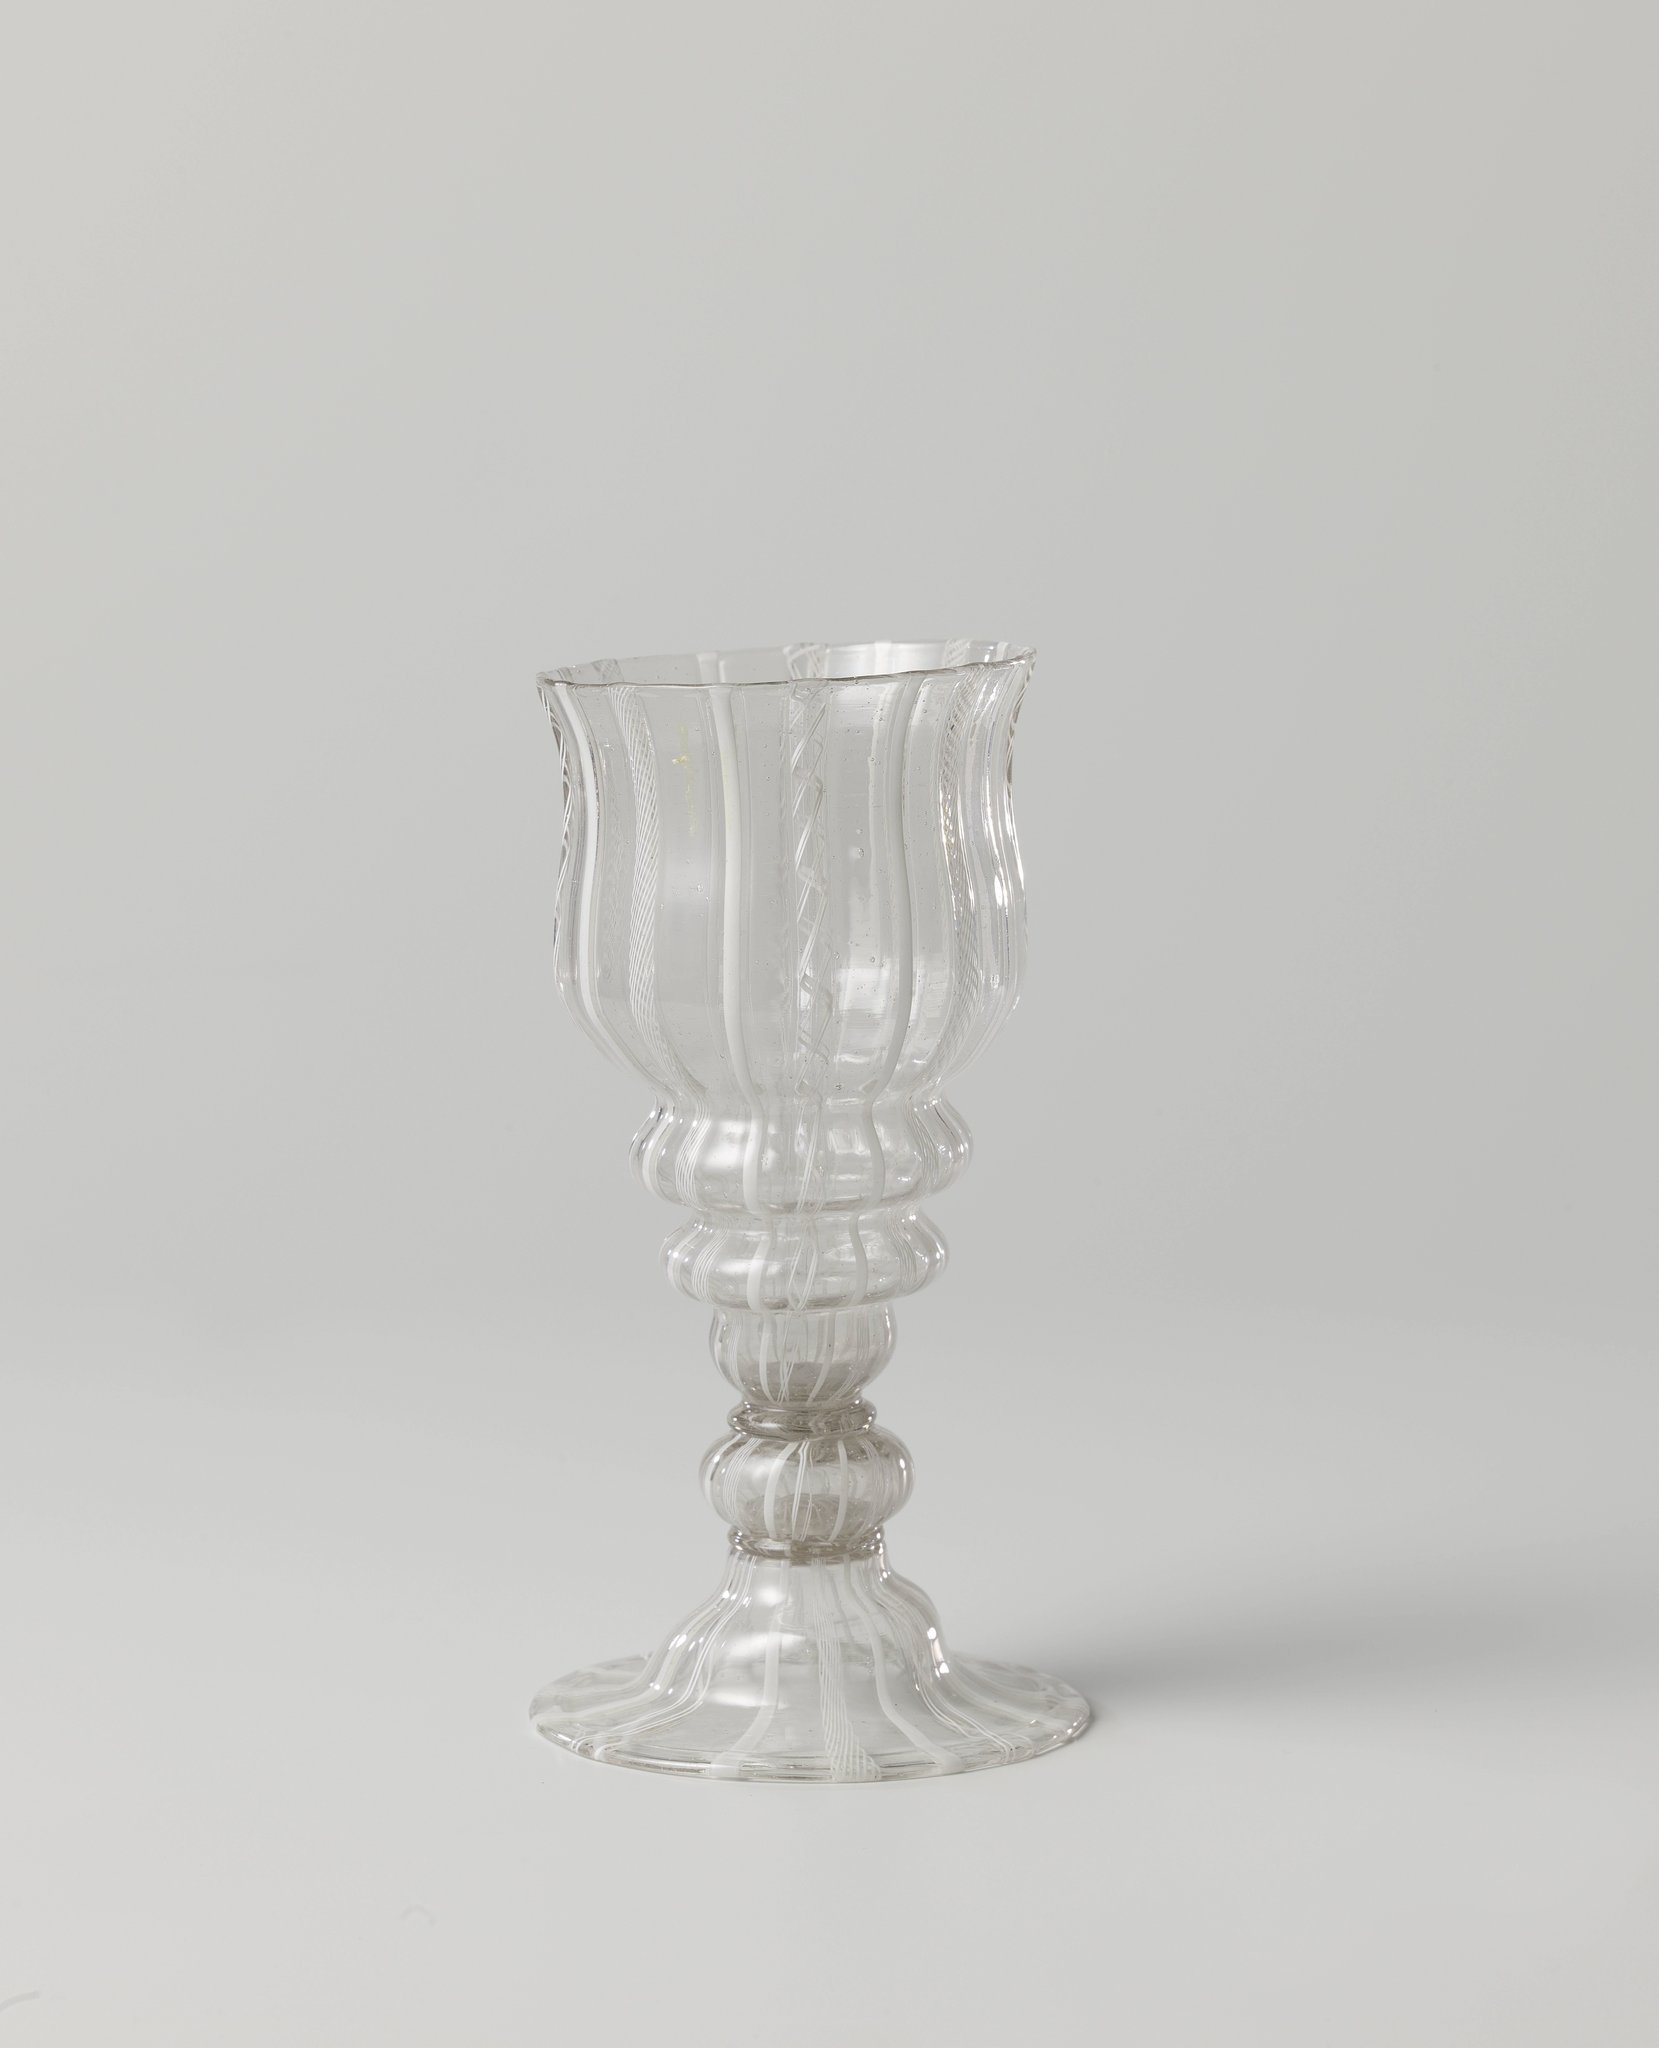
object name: goblet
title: Bokaal van filigraanglas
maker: Anonymous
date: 1590-1650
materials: glass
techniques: façon de venise, glassblowing, vetro a retorti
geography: low countries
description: Bokaal op gewelfde voet met omgeslagen rand. De stam opgebouwd uit een holle nodus tussen twee ringen. Het onderste deel van de kelk drie maal ingesnoerd, het bovenste klokvormig. Voet, stam en kelk van filigraanglas a fili en a retortoli. De ringen van kleurloos glas